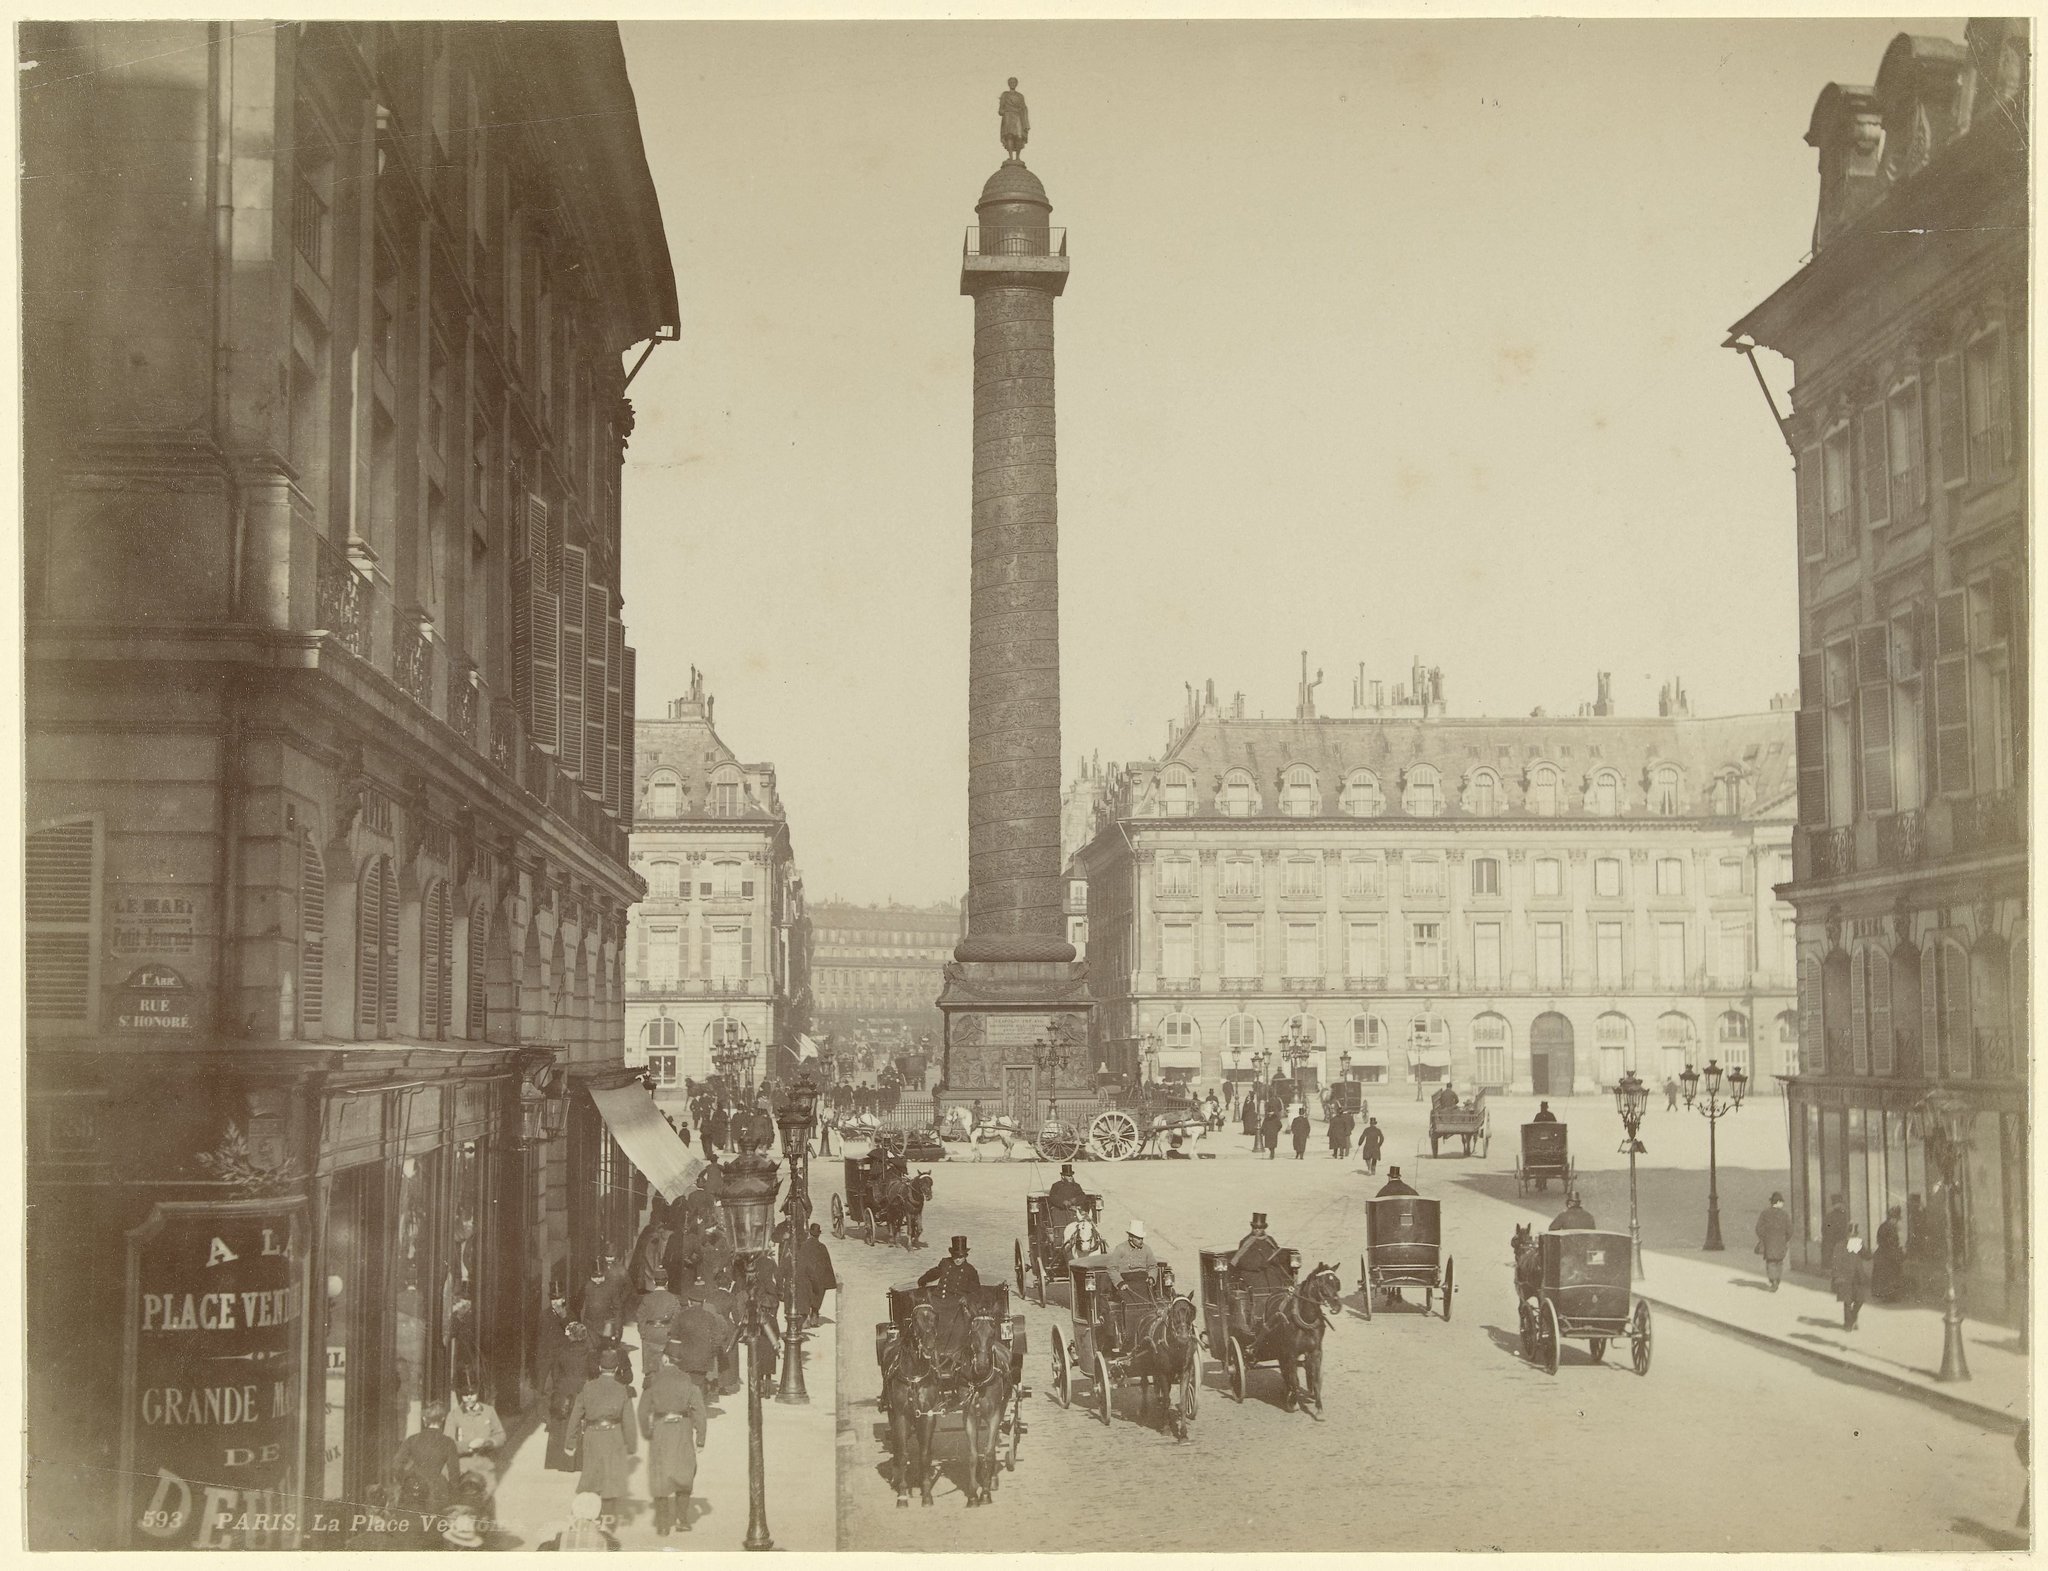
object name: photograph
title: Place Vendôme met de Colonne Vendôme te Parijs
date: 1887-1900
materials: cardboard, paper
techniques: albumen print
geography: paris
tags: square, place, circus, etc., triumphal column with helical friezes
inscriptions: inscription: ‘593 Paris. La Place Vendôme X. Phot.’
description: Tussen 1887 en ca. 1900 werkten Neurdein frères onder andere onder de naam 'X phot.'.